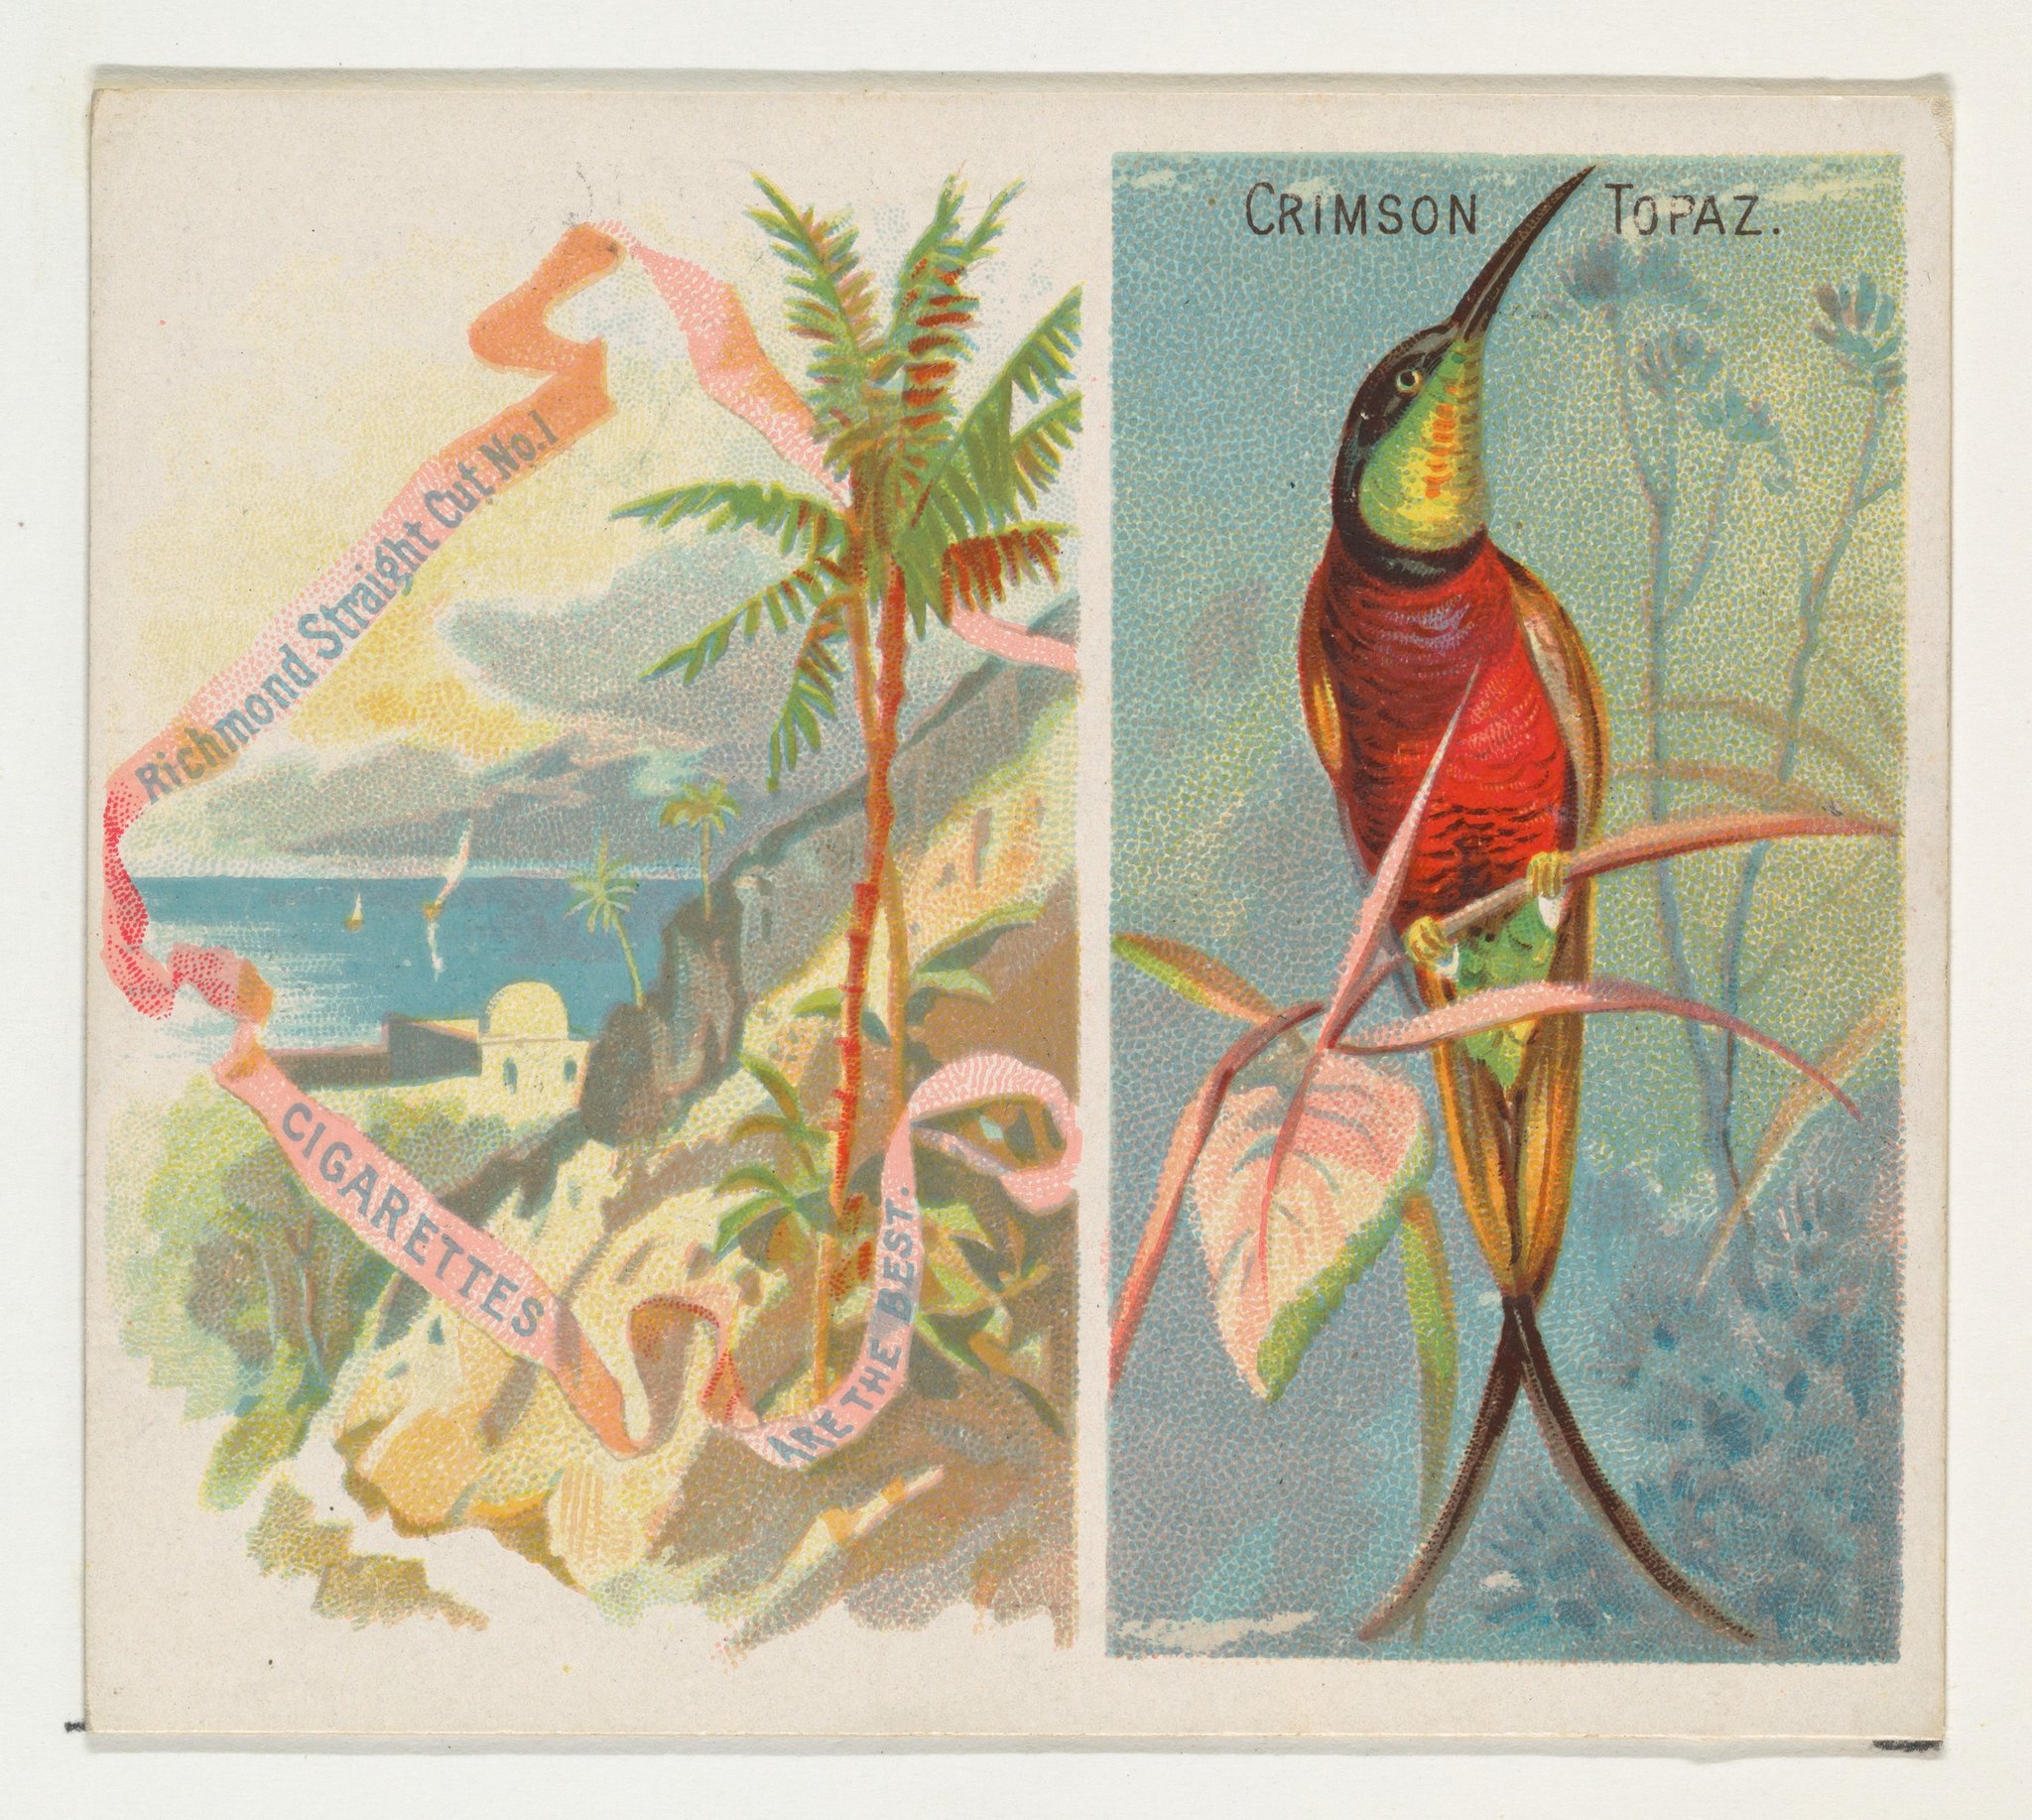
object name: print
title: Crimson Topaz, from Birds of the Tropics series (N38) for Allen & Ginter Cigarettes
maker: allen & ginter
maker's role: publisher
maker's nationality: american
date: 1889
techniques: color lithograph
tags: birds